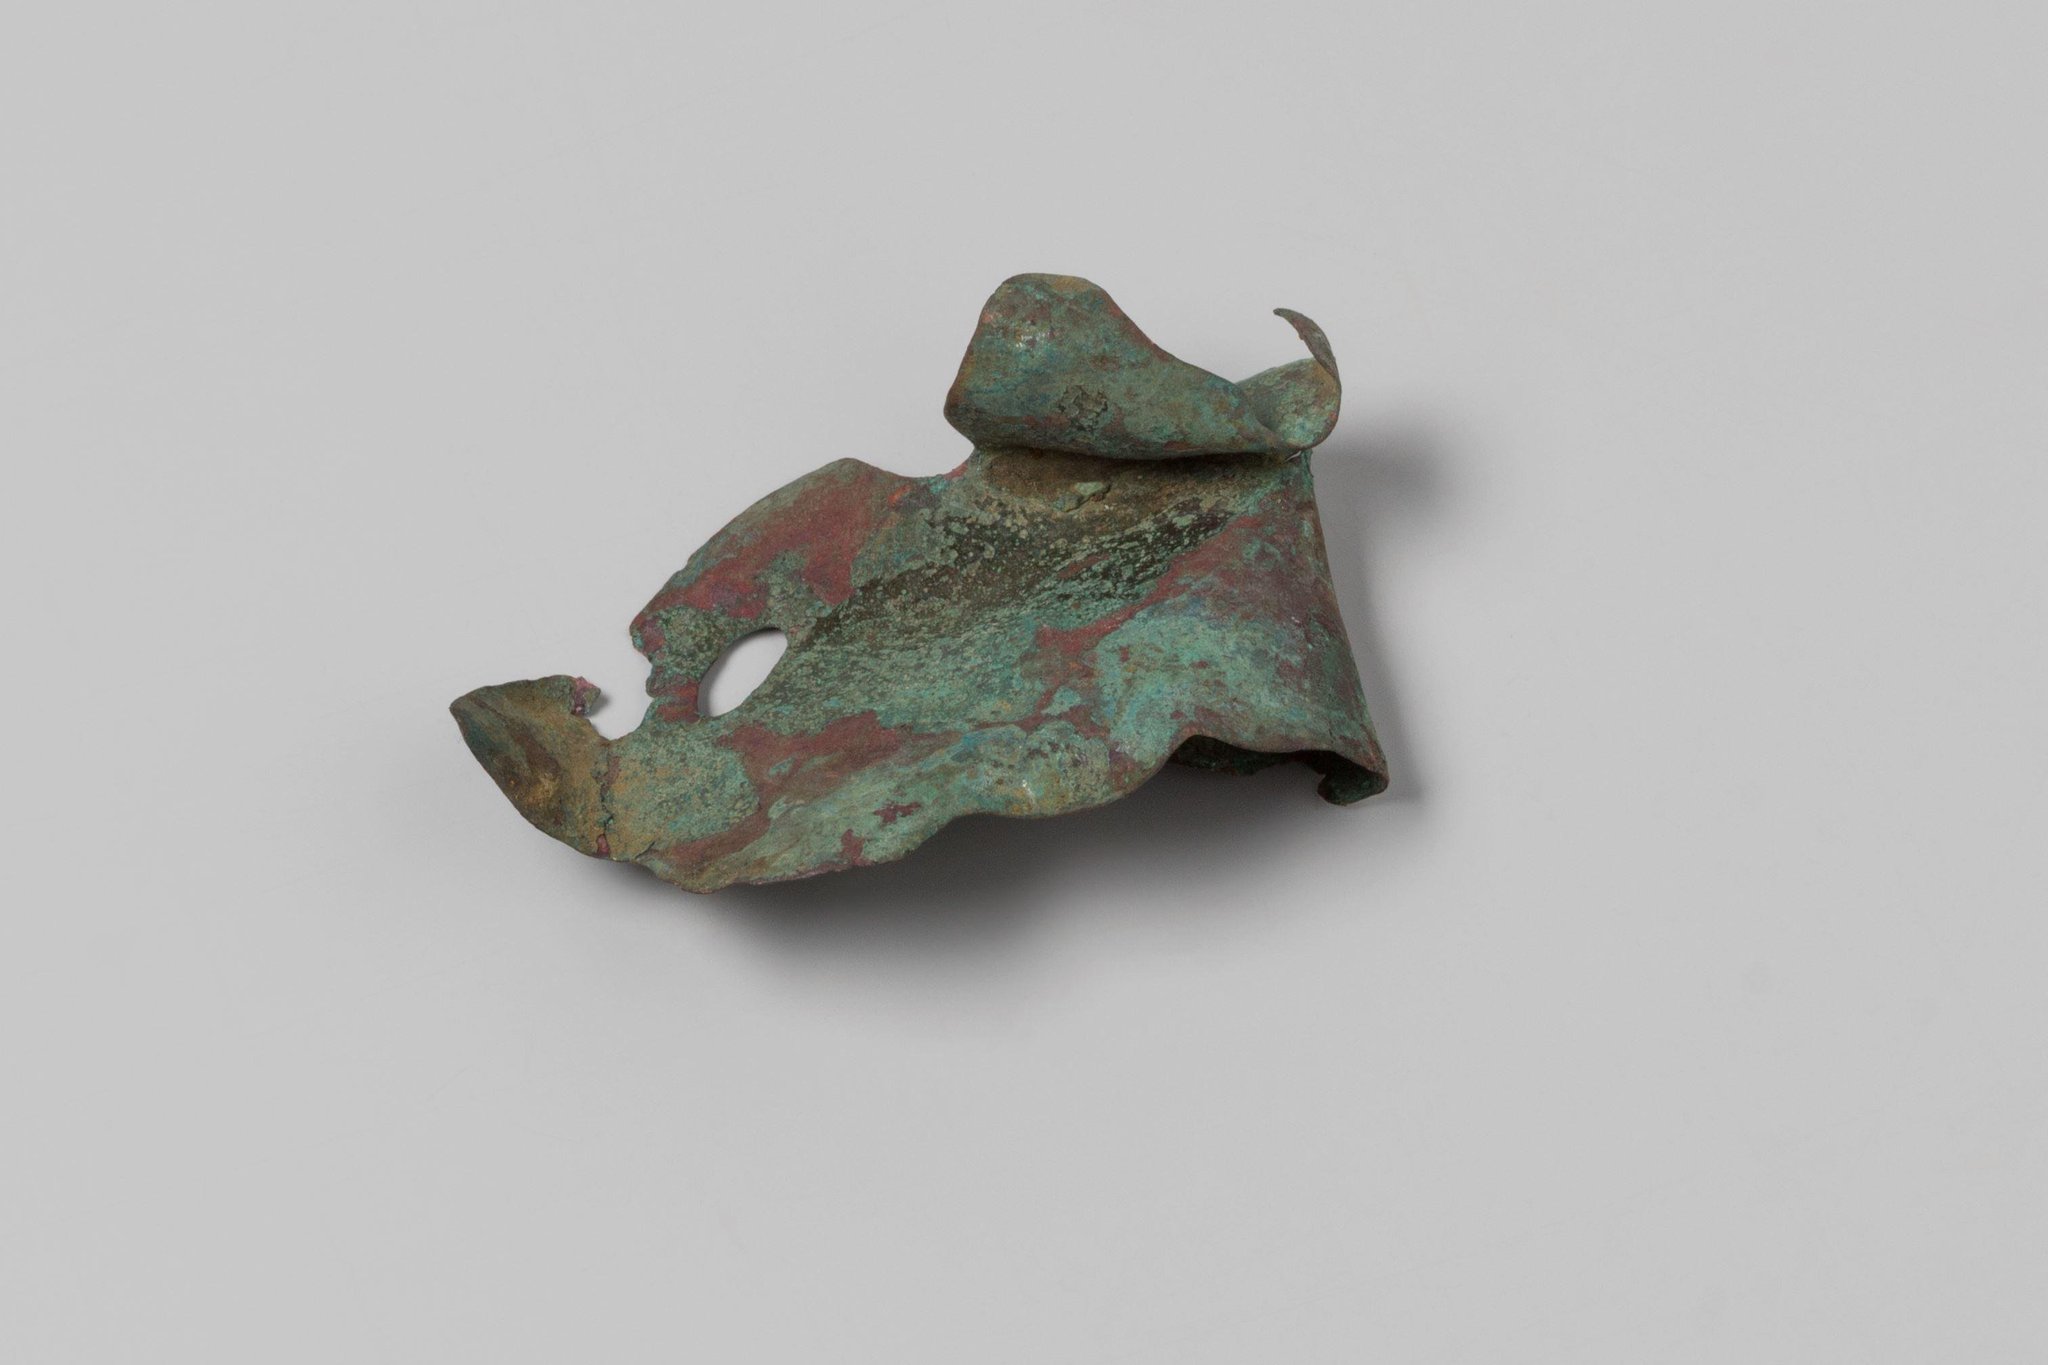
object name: fragment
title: Fragment koper uit het wrak van de Oost-Indiëvaarder Hollandia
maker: Anonymous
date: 1700-1743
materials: copper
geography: netherlands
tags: verenigde oostindische compagnie, hollandia (schip), annet